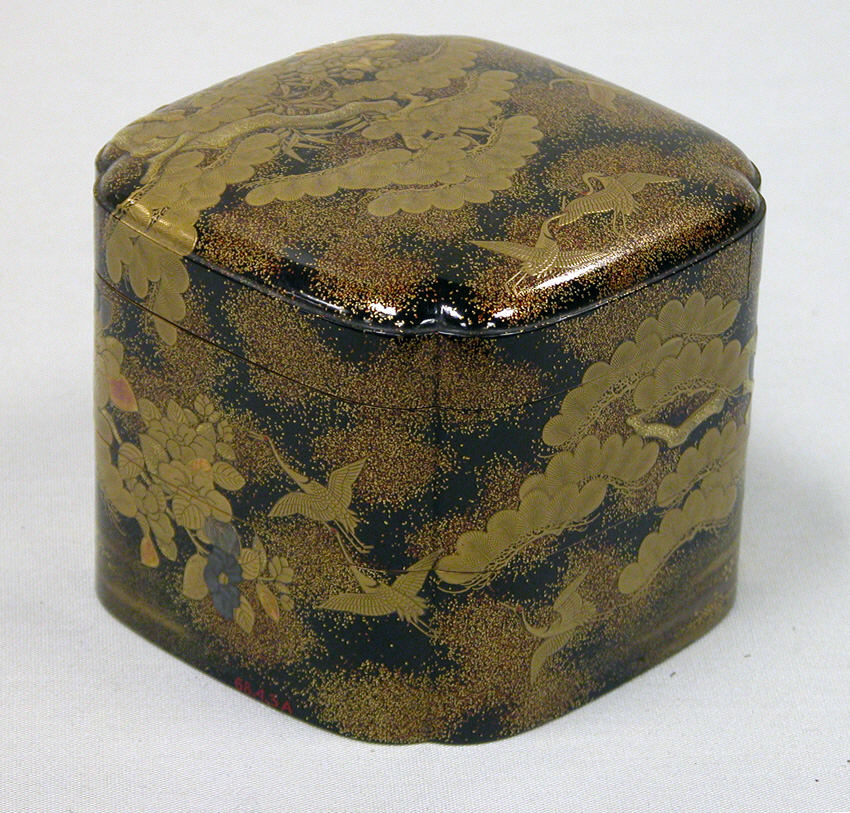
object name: box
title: Box (Jubako)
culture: japanese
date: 1701-1800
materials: gold, lacquer, silver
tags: birds,trees